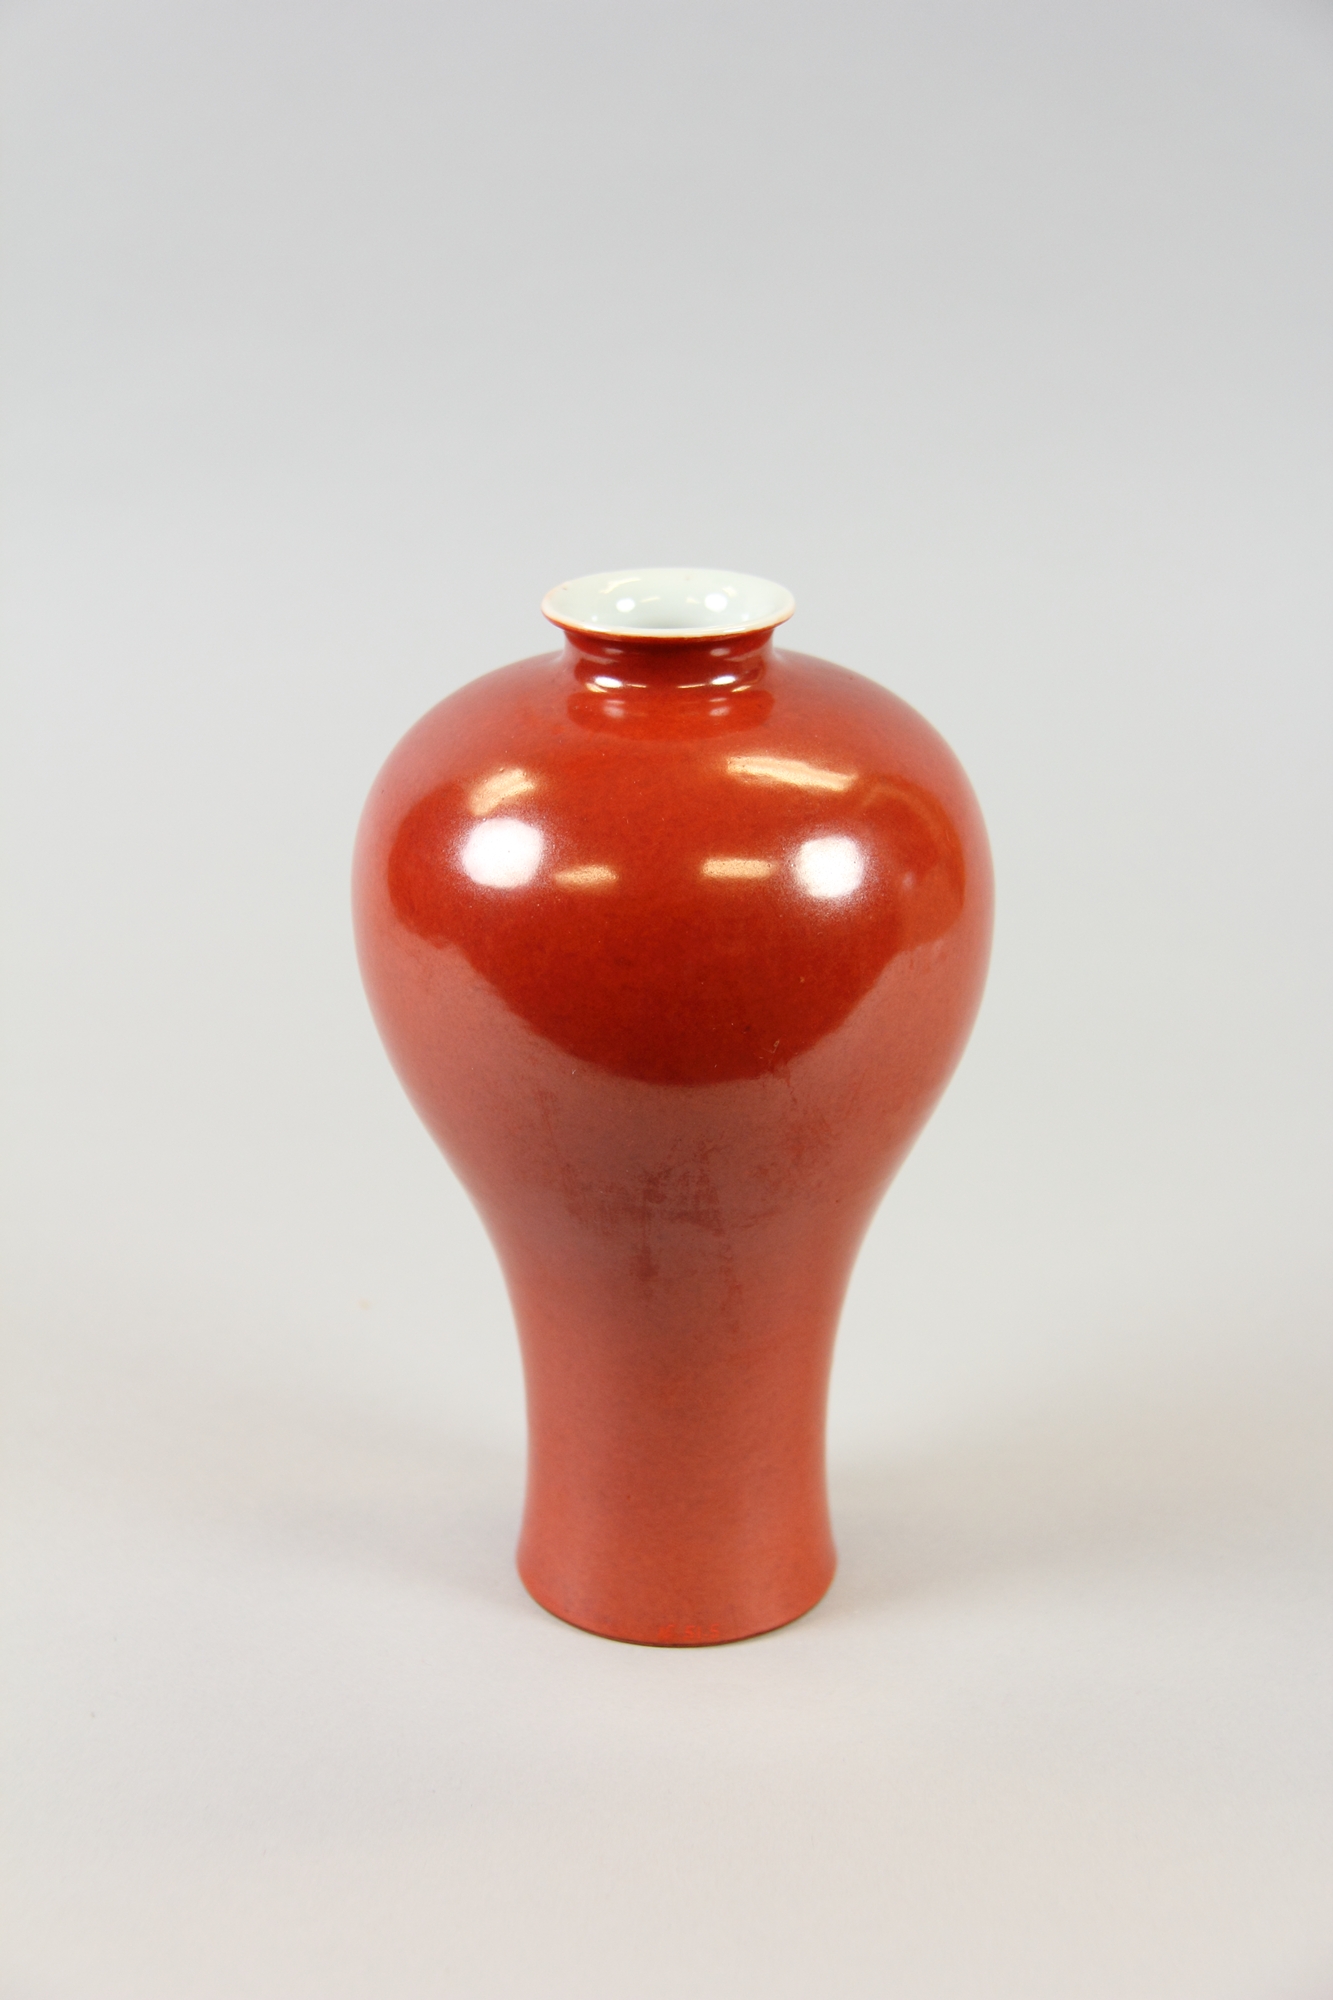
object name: vase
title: Meiping vase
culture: chinese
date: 1901-2000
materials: coral, glaze, porcelain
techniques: painting